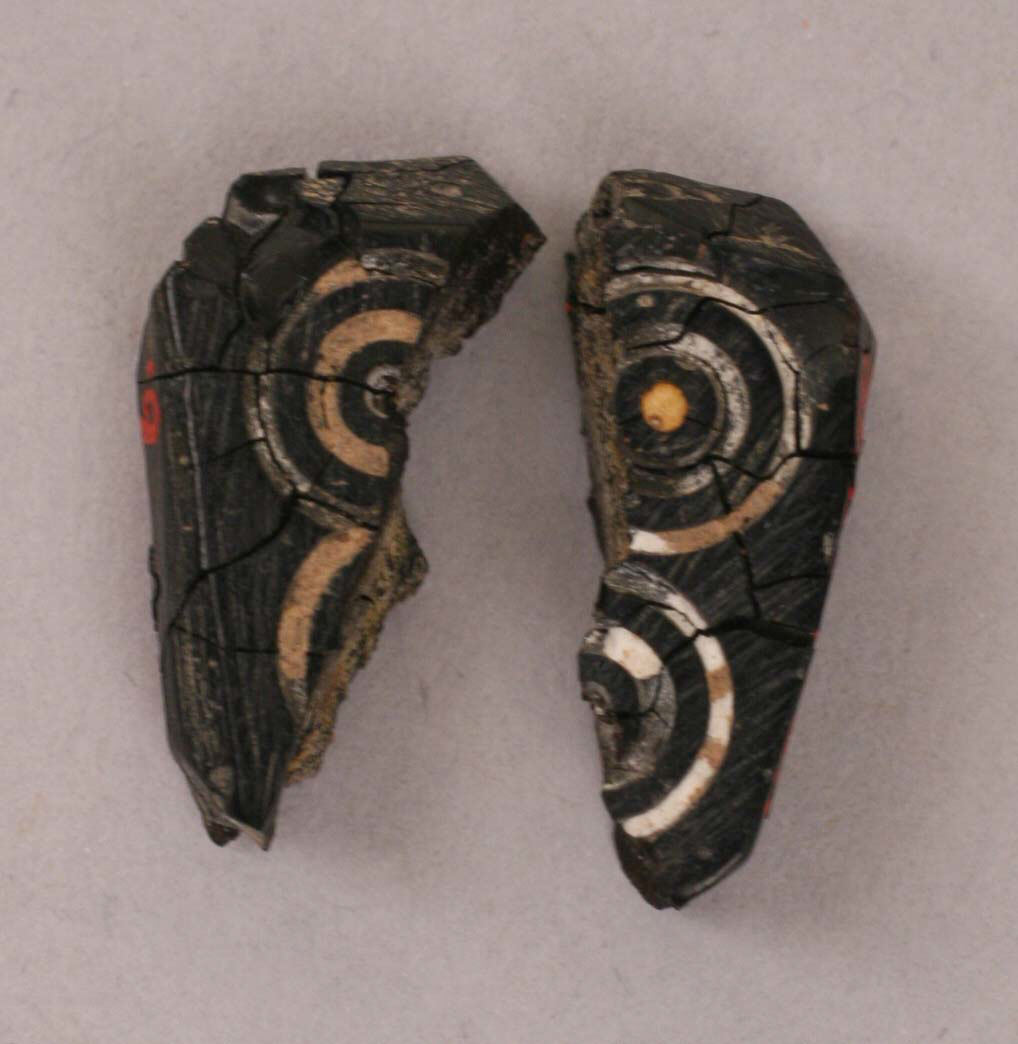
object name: bead fragment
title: Fragments of a Bead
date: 701-1300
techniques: cutting, inlay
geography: iran